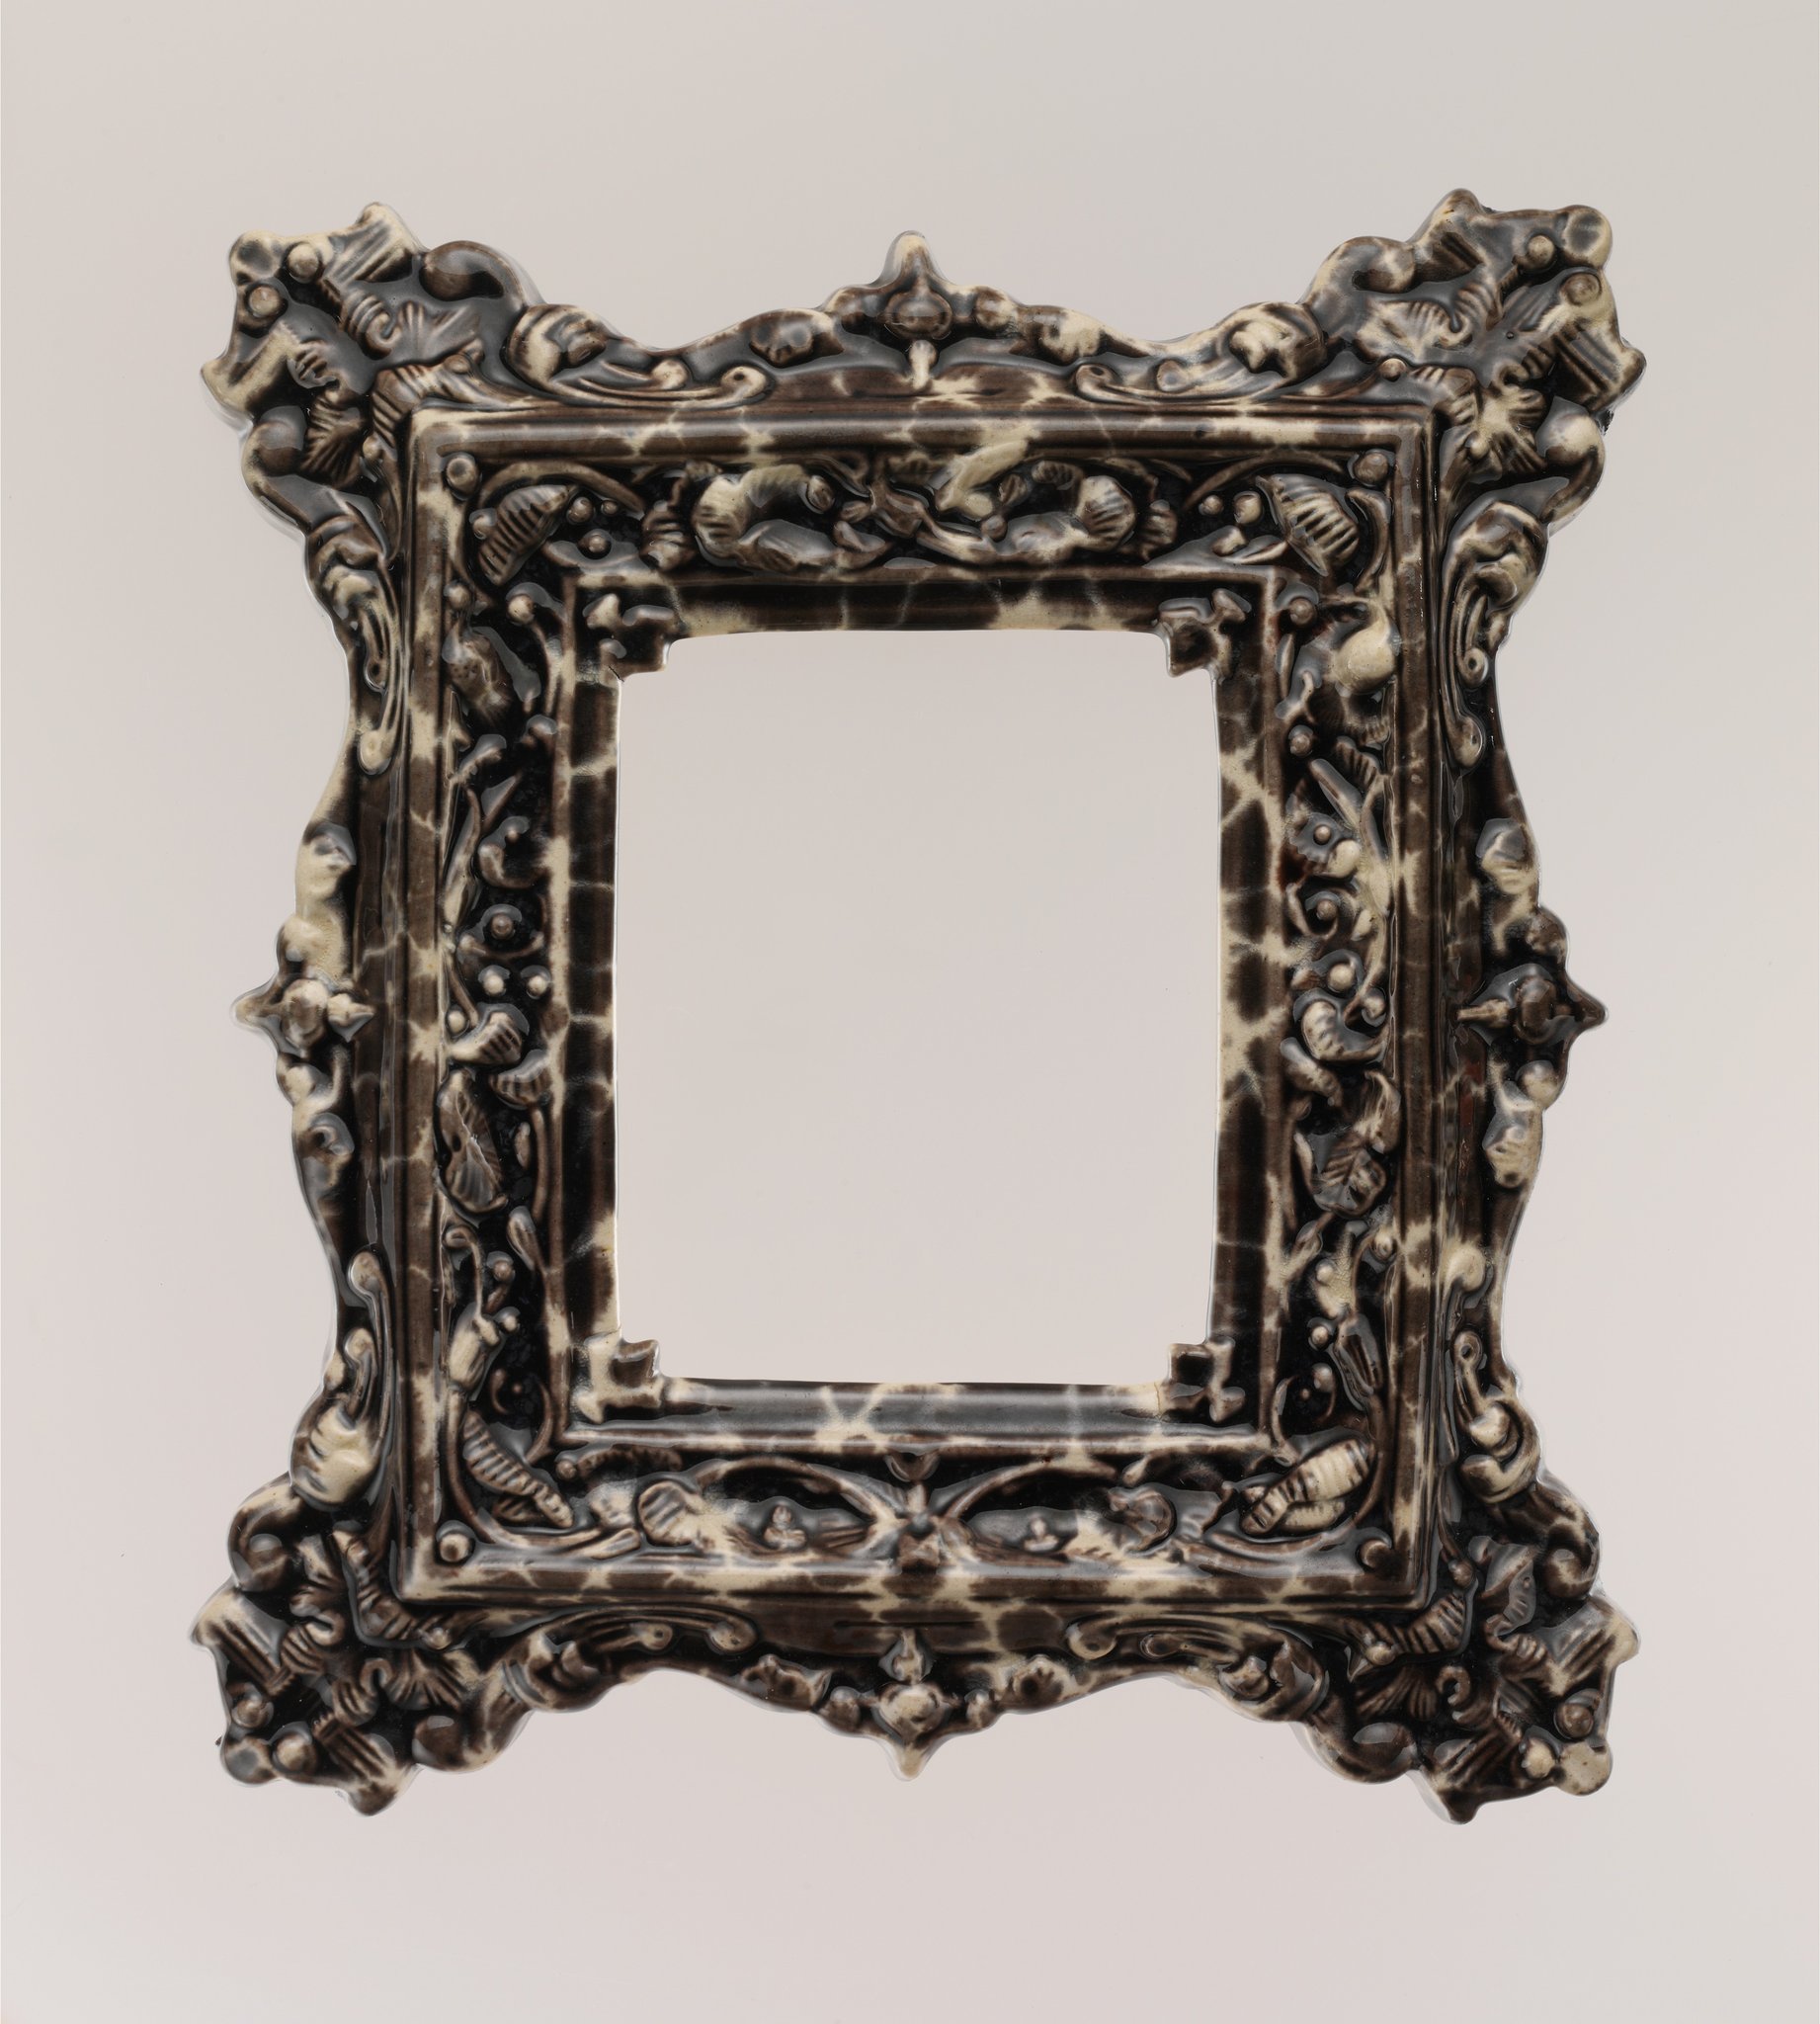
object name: frame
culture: american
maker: united states pottery company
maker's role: manufacturer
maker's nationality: american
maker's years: 1852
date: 1849-1858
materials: earthenware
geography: united states